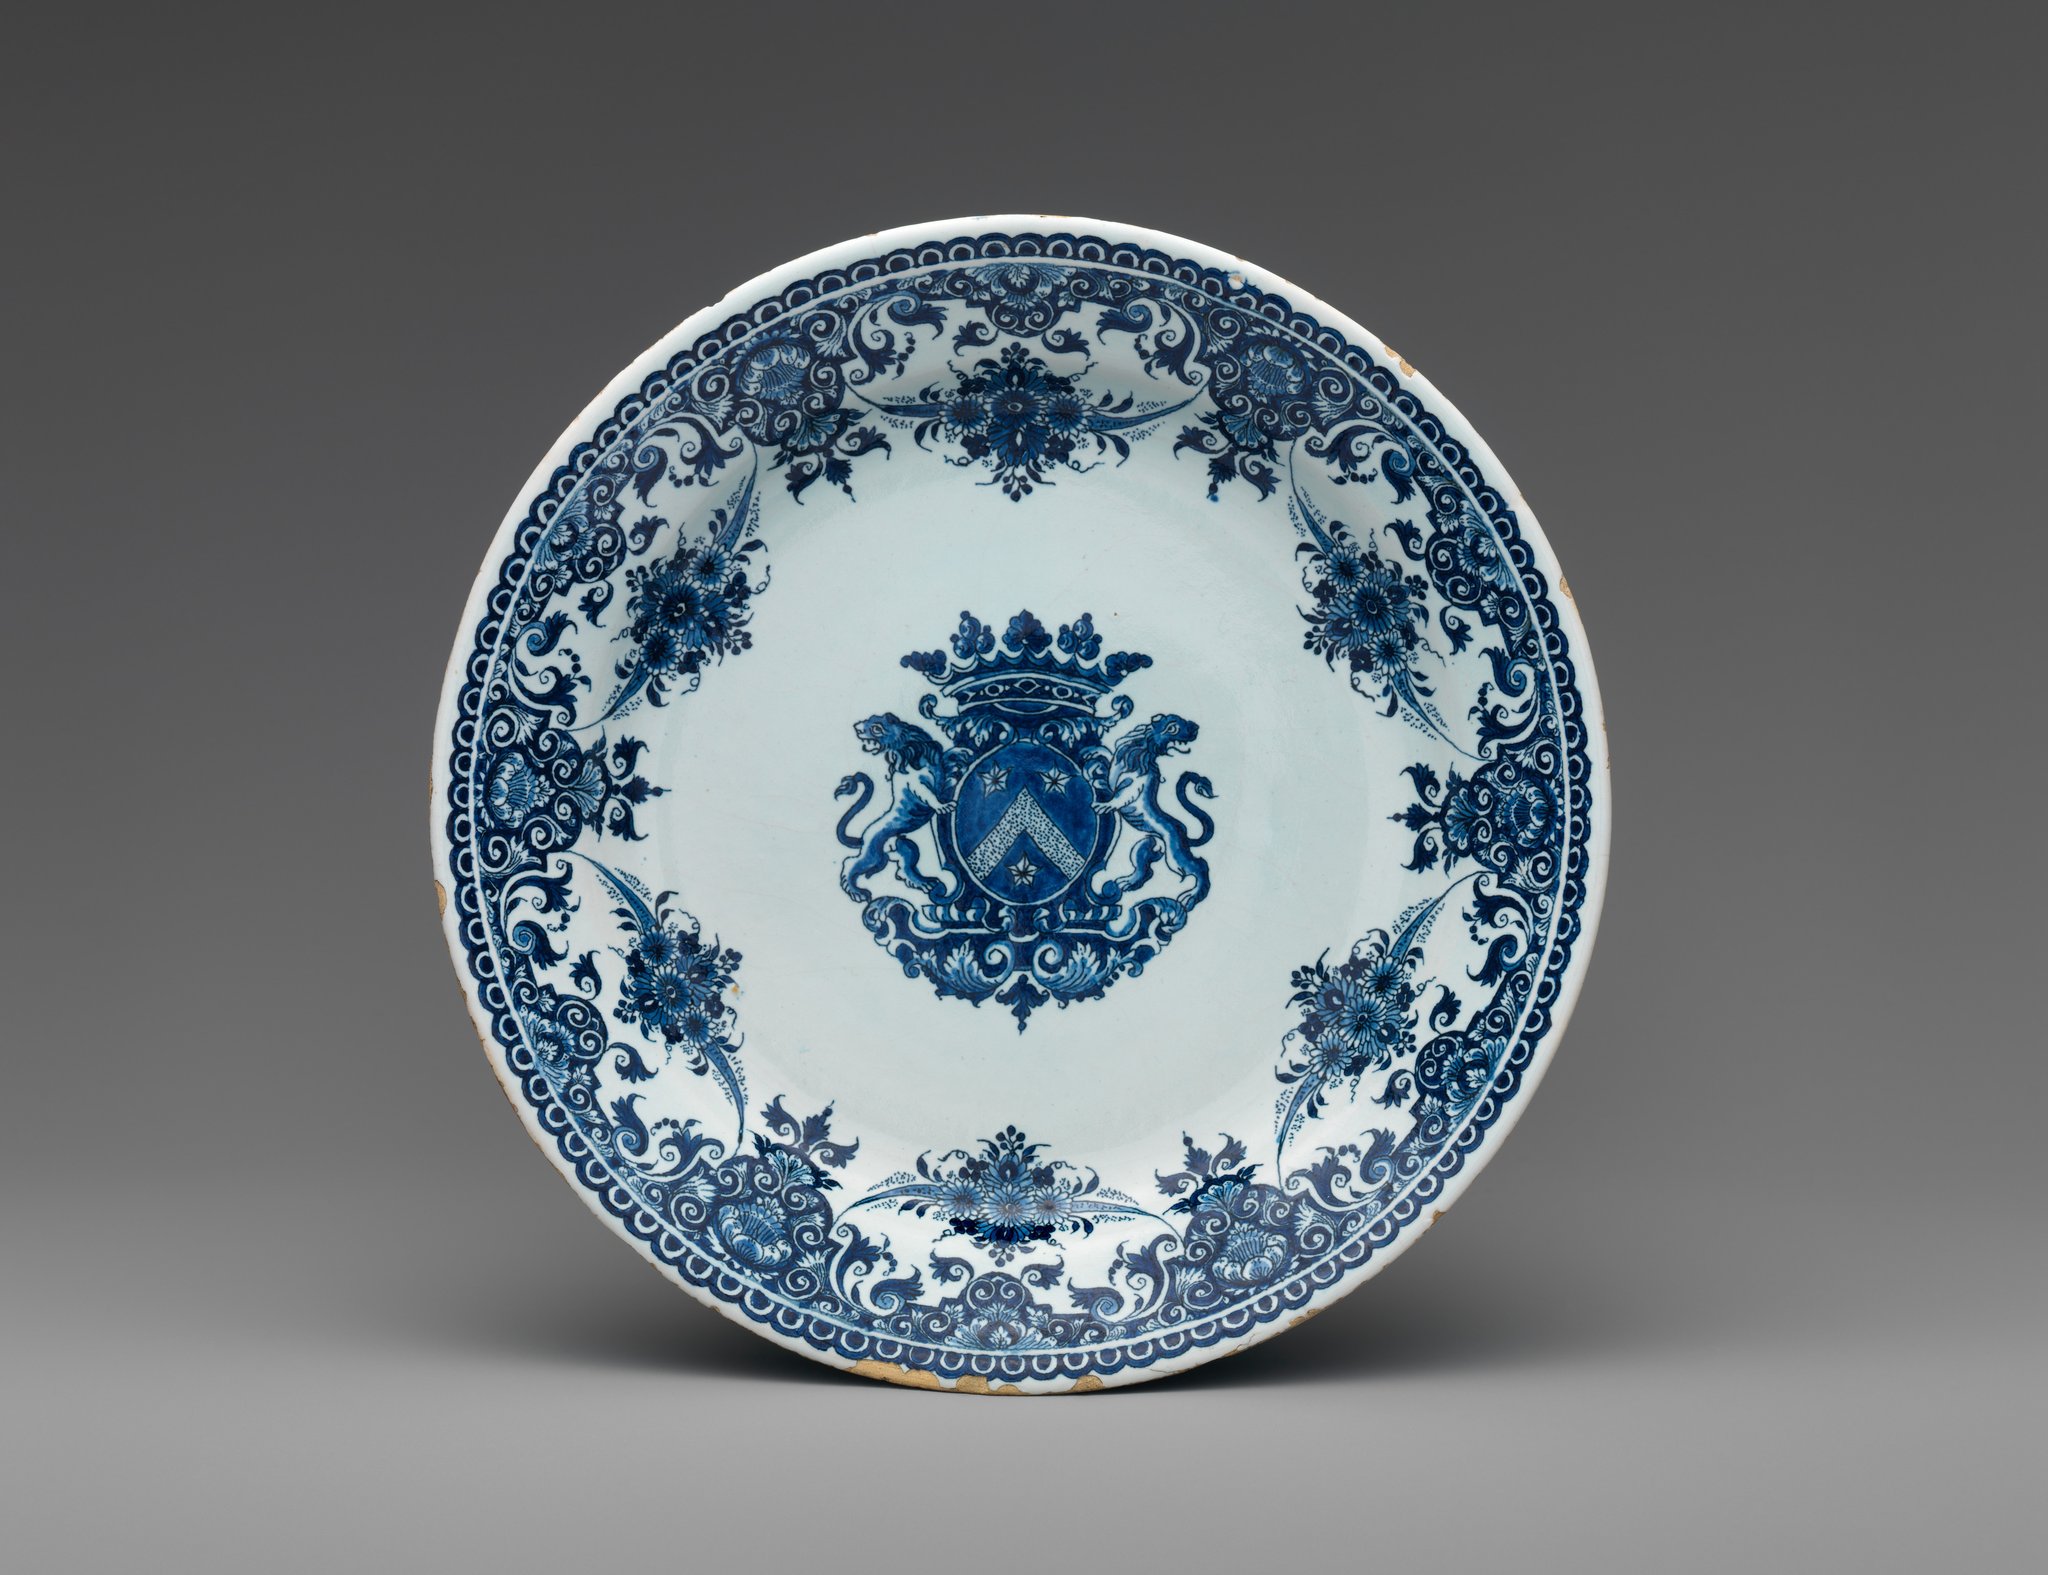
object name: plate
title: Plate with arms of the Poterat family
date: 1710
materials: faience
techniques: glazing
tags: flowers,coat of arms